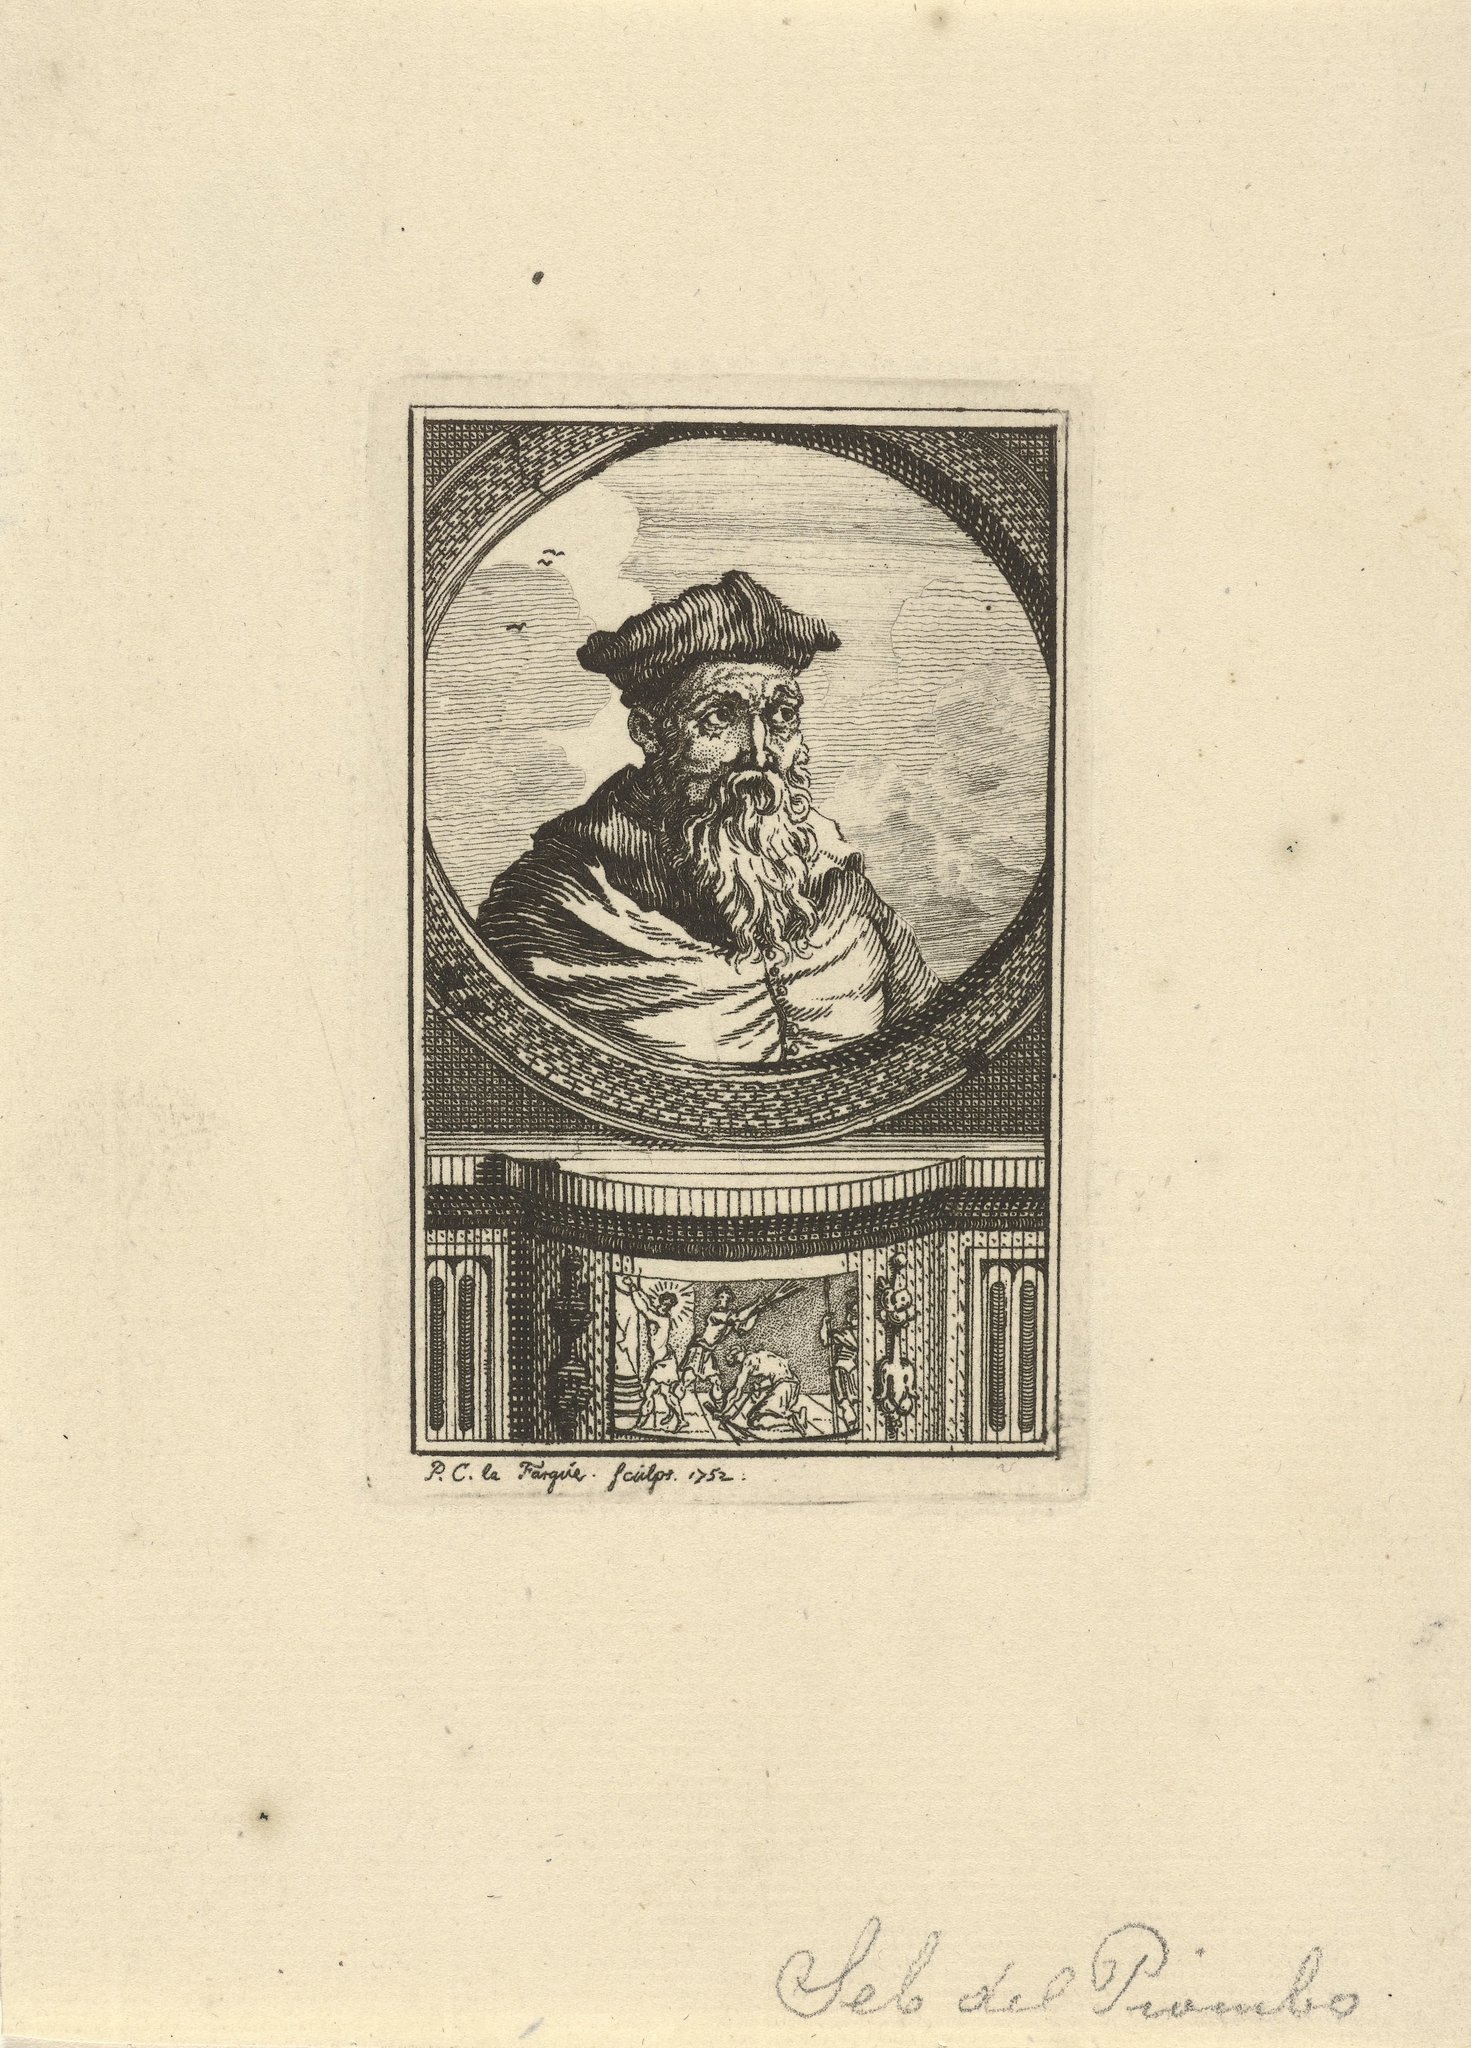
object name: print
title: Portret van Sebastiano del Piombo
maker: isaac lodewijk la fargue van nieuwland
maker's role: draughtsman, painter, print maker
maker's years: 1726-1805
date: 1752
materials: paper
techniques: etching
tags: venice, rome, painter, draughtsman, sebastiano del piombo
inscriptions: collector's mark: Lugt 2228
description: Prent opgenomen in: Dézallier d'Argenville, Antoine Joseph. Tooneel der uitmuntende schilders van Europa, en byzonderlyk van Nederland. Den Haag: Mattheus Gaillard, 1752.